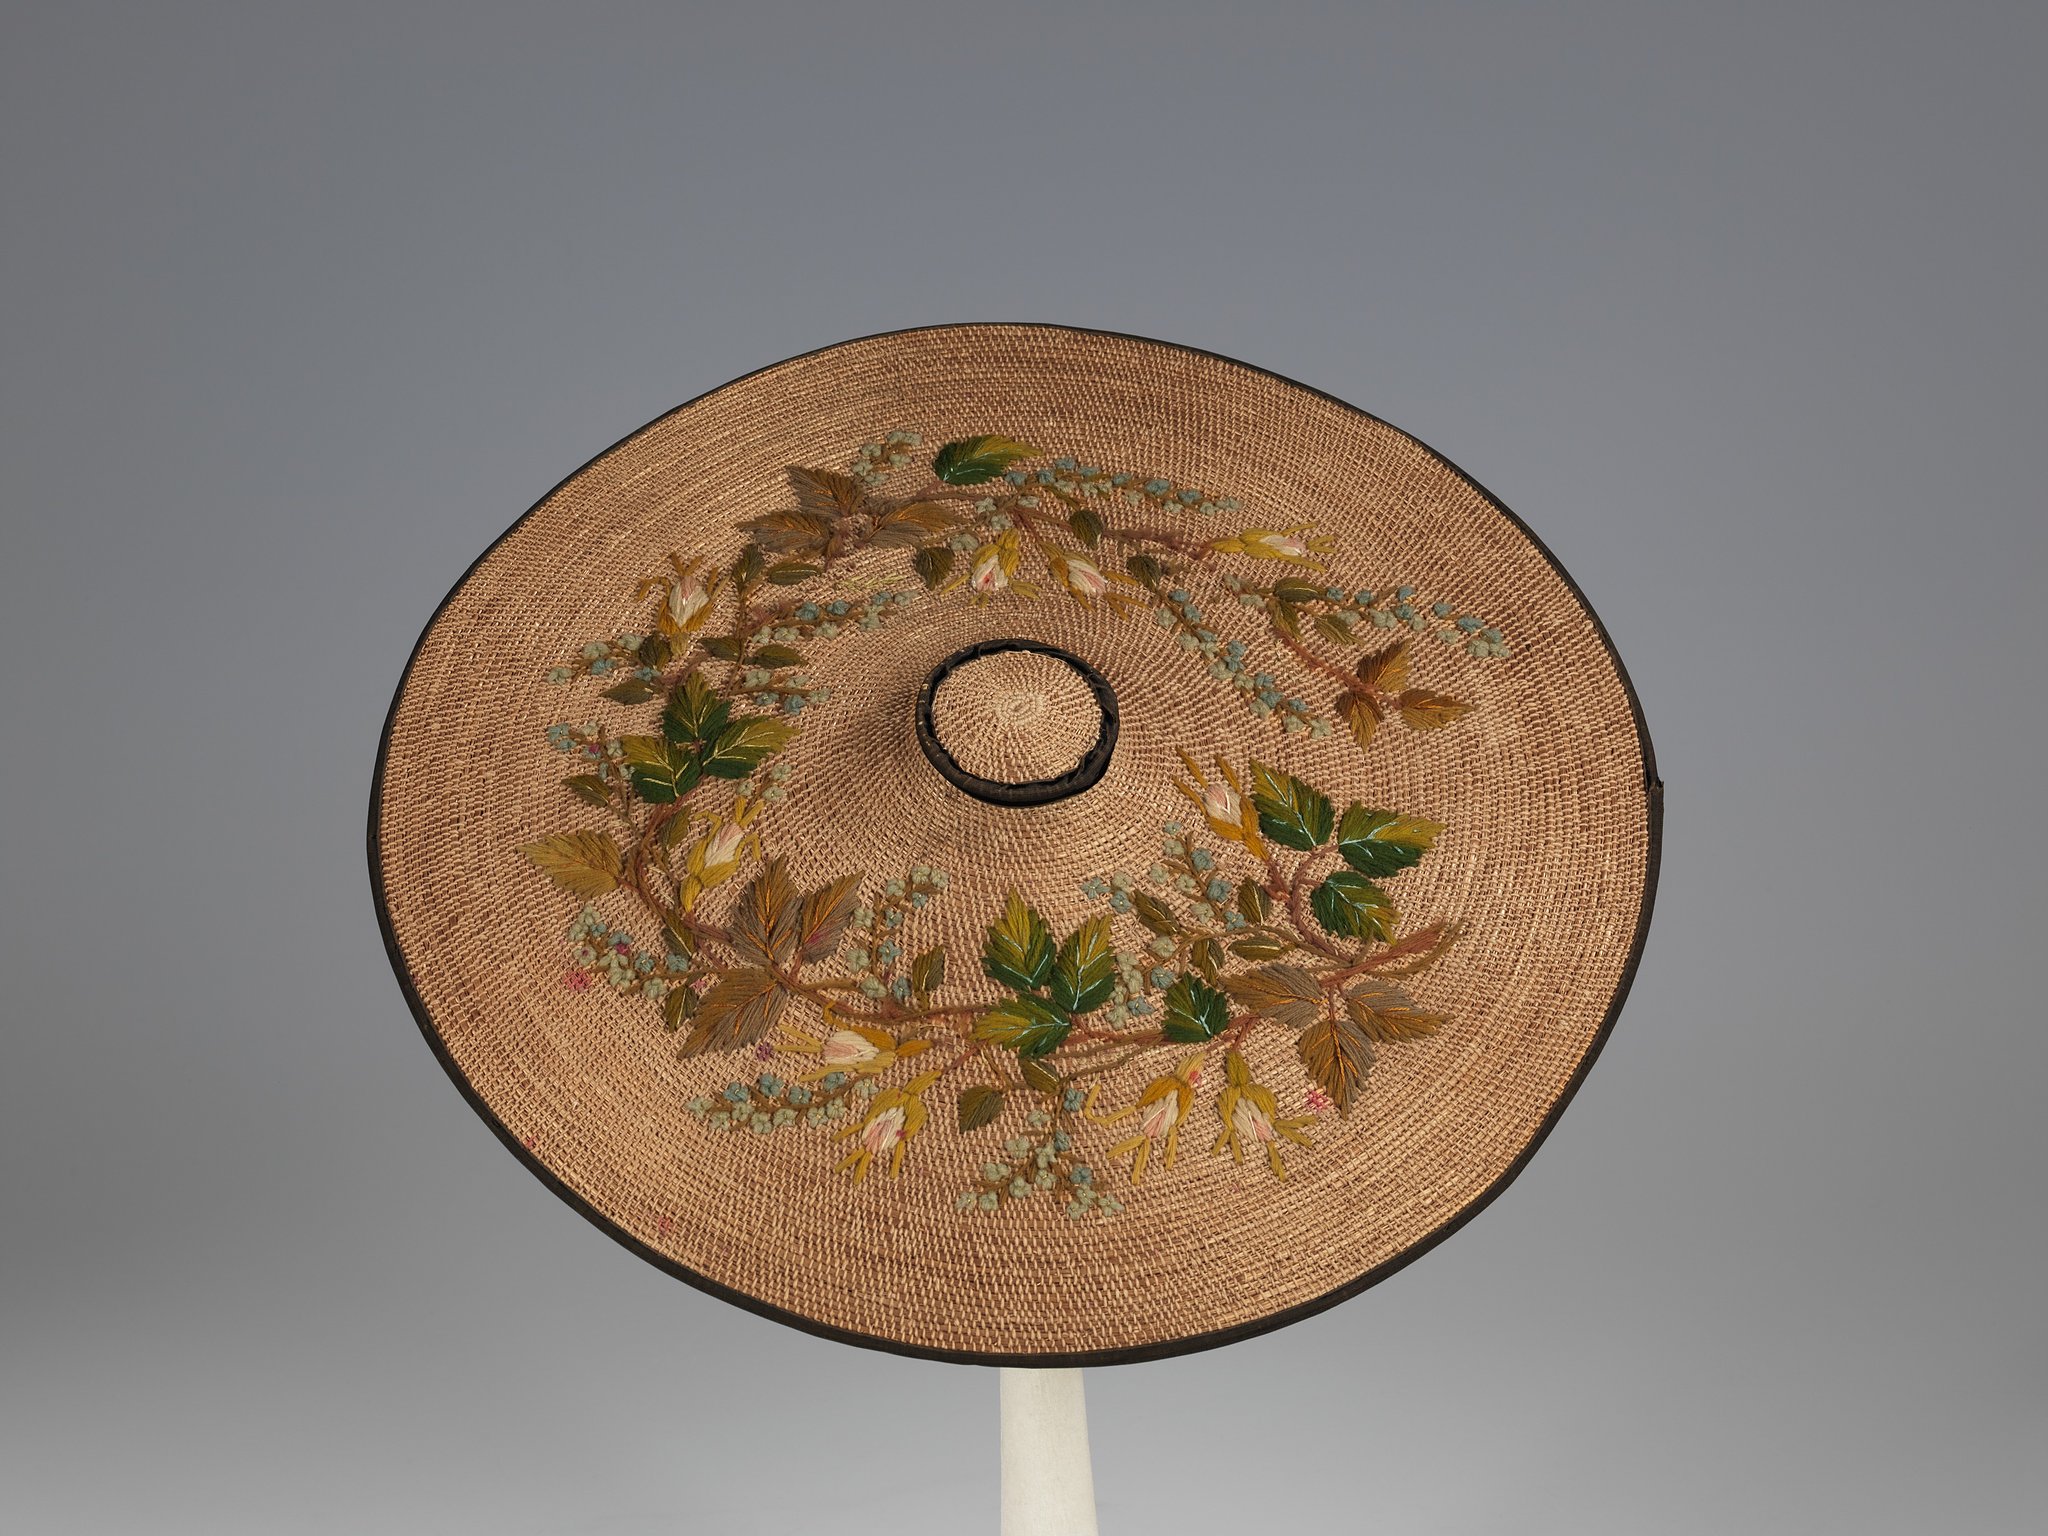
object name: hat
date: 1901-1933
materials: cotton, fiber, wool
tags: leaves